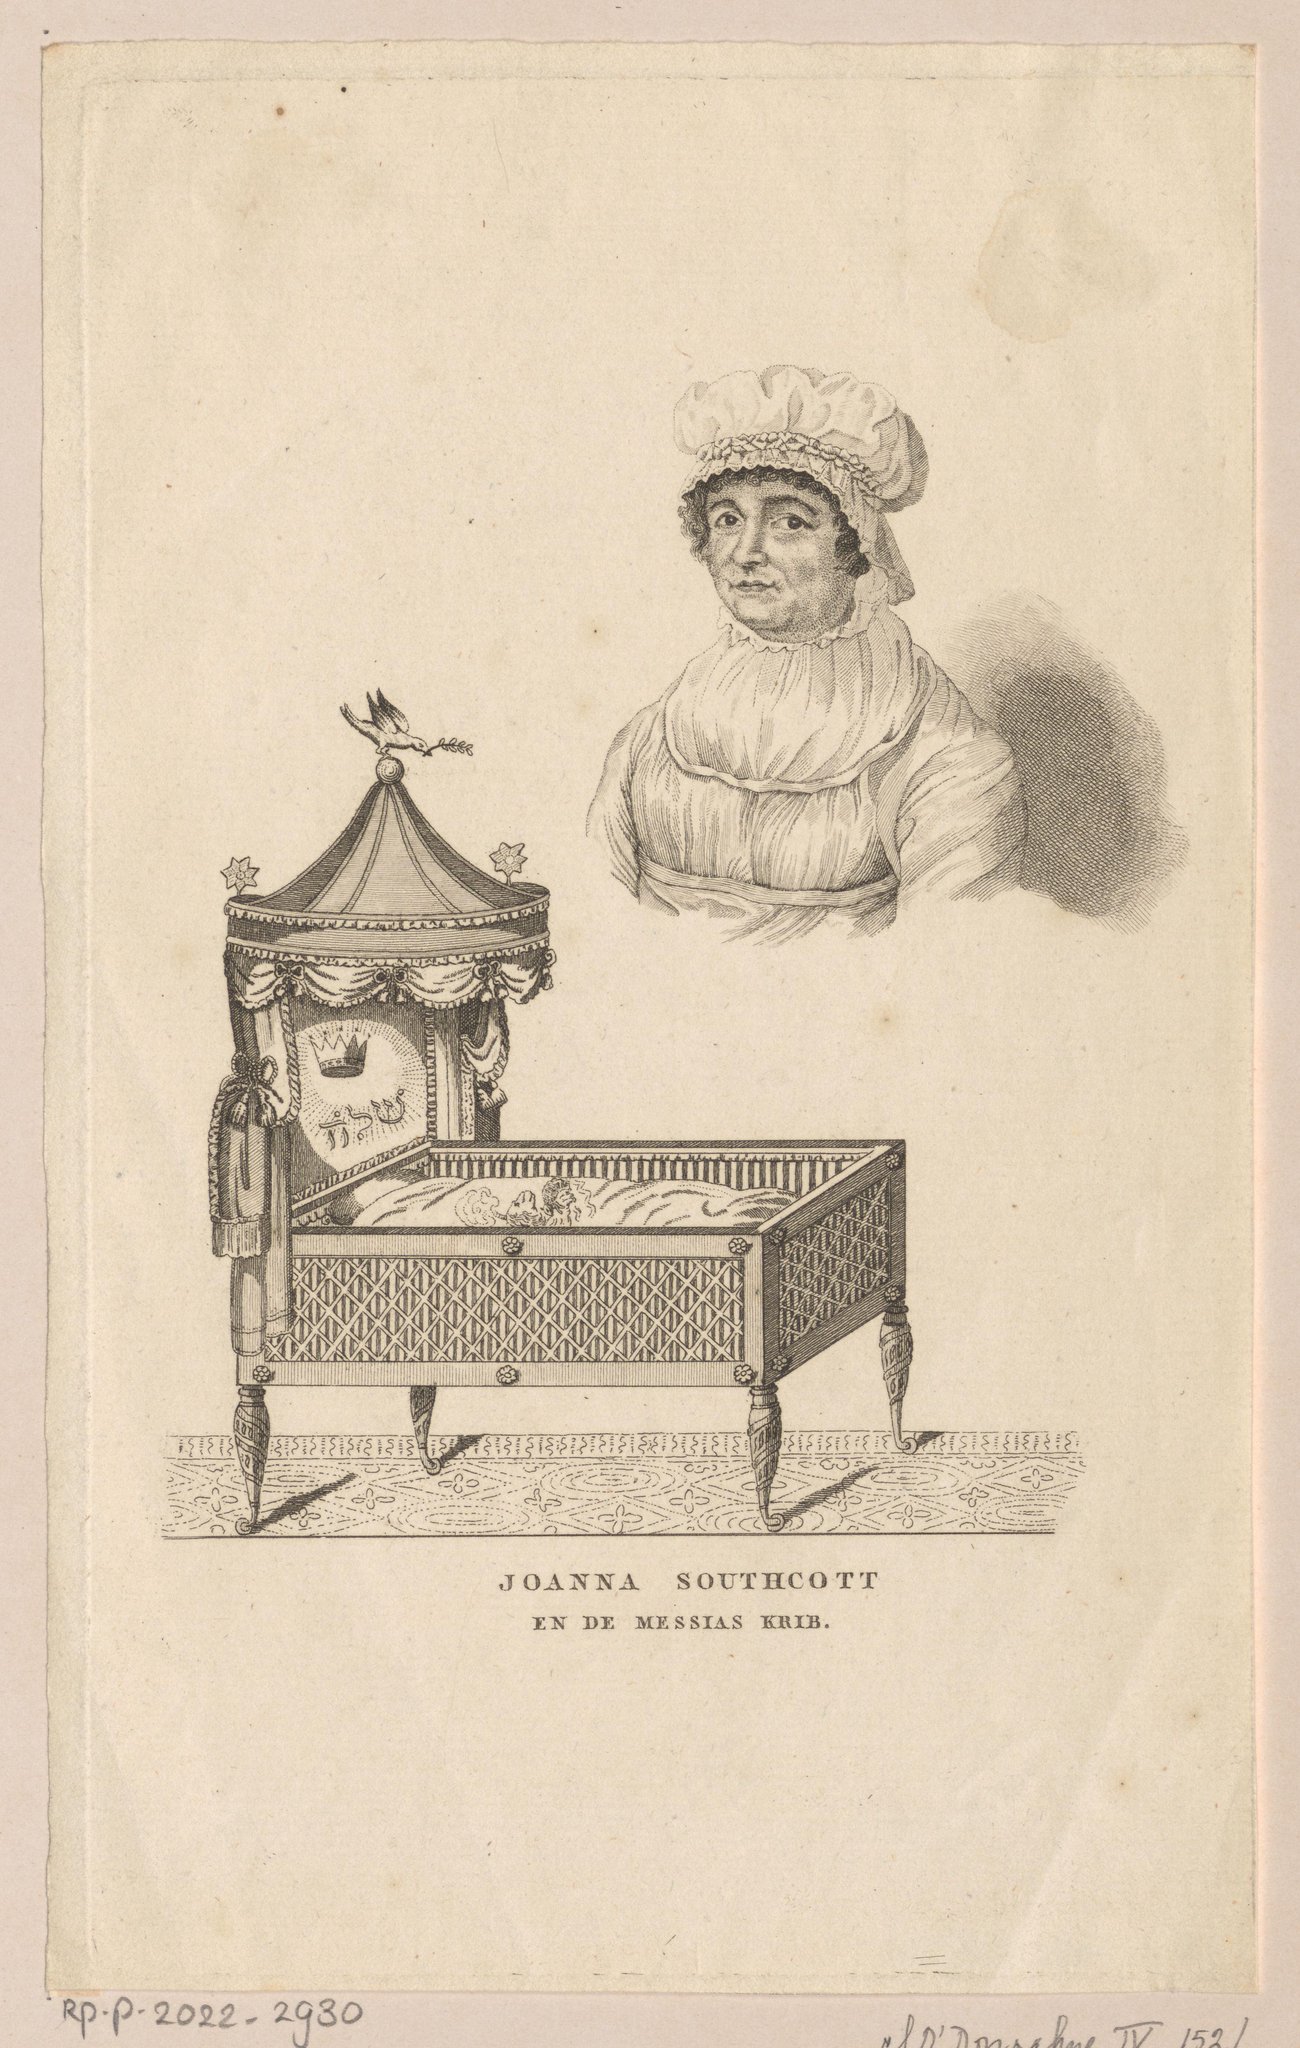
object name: print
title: Joanna Southcott en de messias krib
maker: Anonymous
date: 1822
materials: paper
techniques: etching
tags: historical persons - bb - woman, cradle, crib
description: Southcott beweerde dat zij zwanger was van de nieuwe messias, die 19 oktober 1814 geboren zou worden. Prent waarschijnlijk uit: Niemeyer, August Hermann. Waarnemingen op eene reize naar Engeland in 1819 (...). Haarlem: Adriaan Loosjes, 1822, dl. 2.